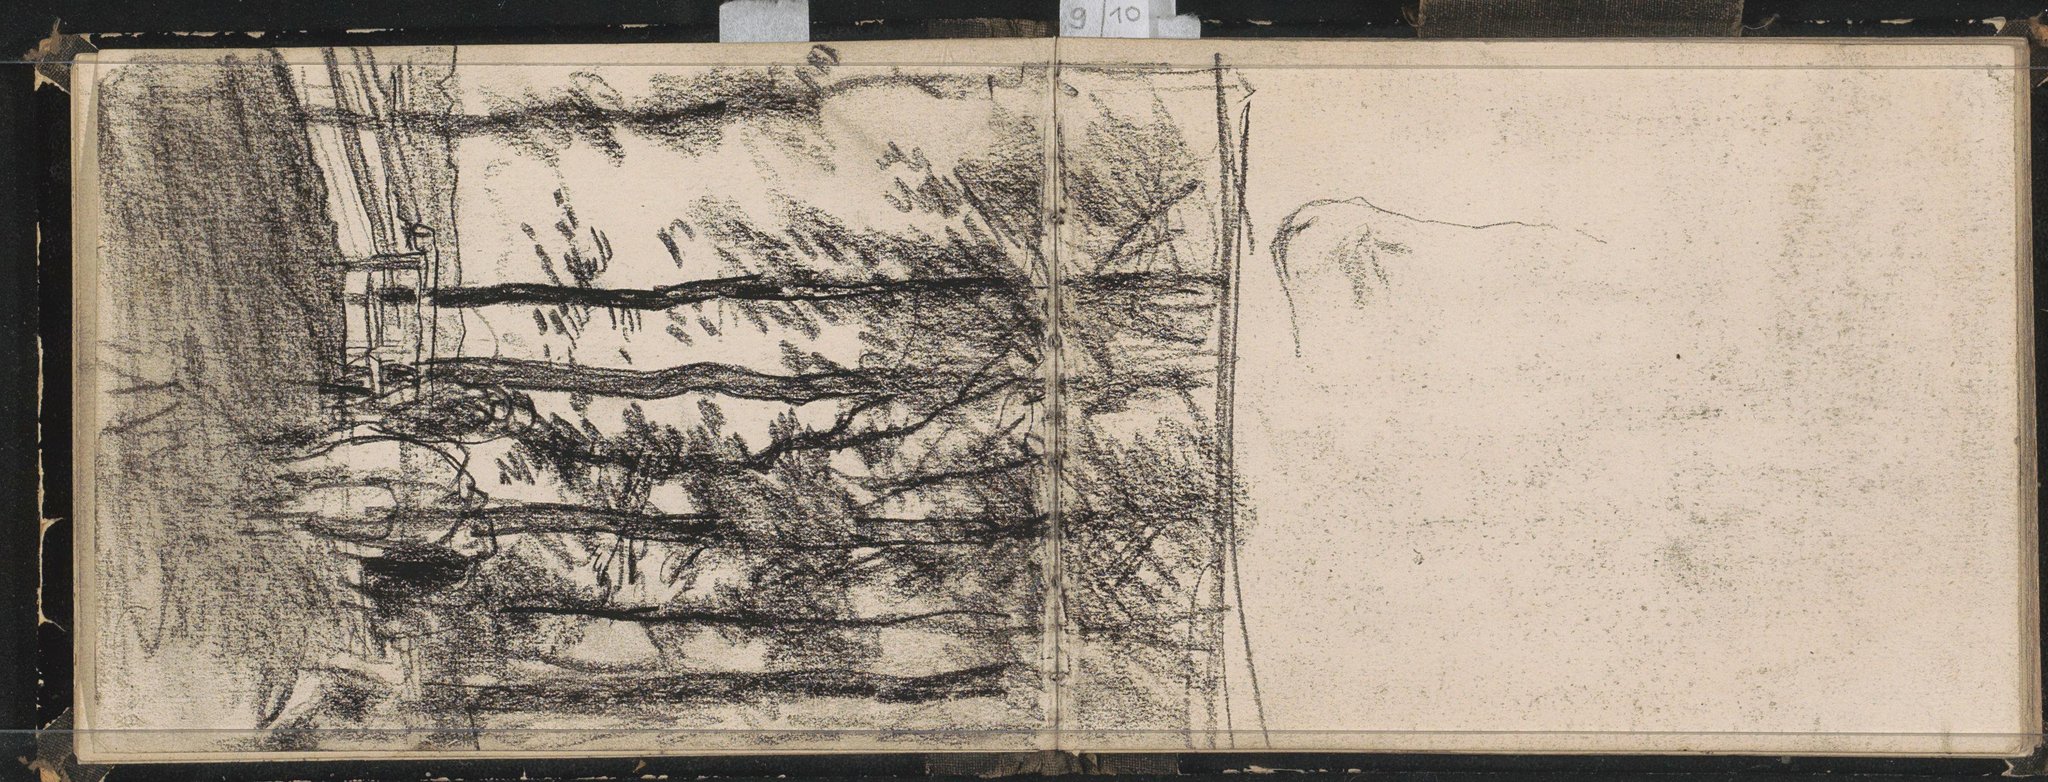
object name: sketchbook leaf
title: Landschap met een rij bomen en een hek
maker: anton mauve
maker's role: draughtsman, painter, print maker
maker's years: 1838-1888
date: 1848-1888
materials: chalk, paper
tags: trees, fence, wall, paling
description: Blad 6 verso en 7 recto uit een schetsboek met 33 bladen.